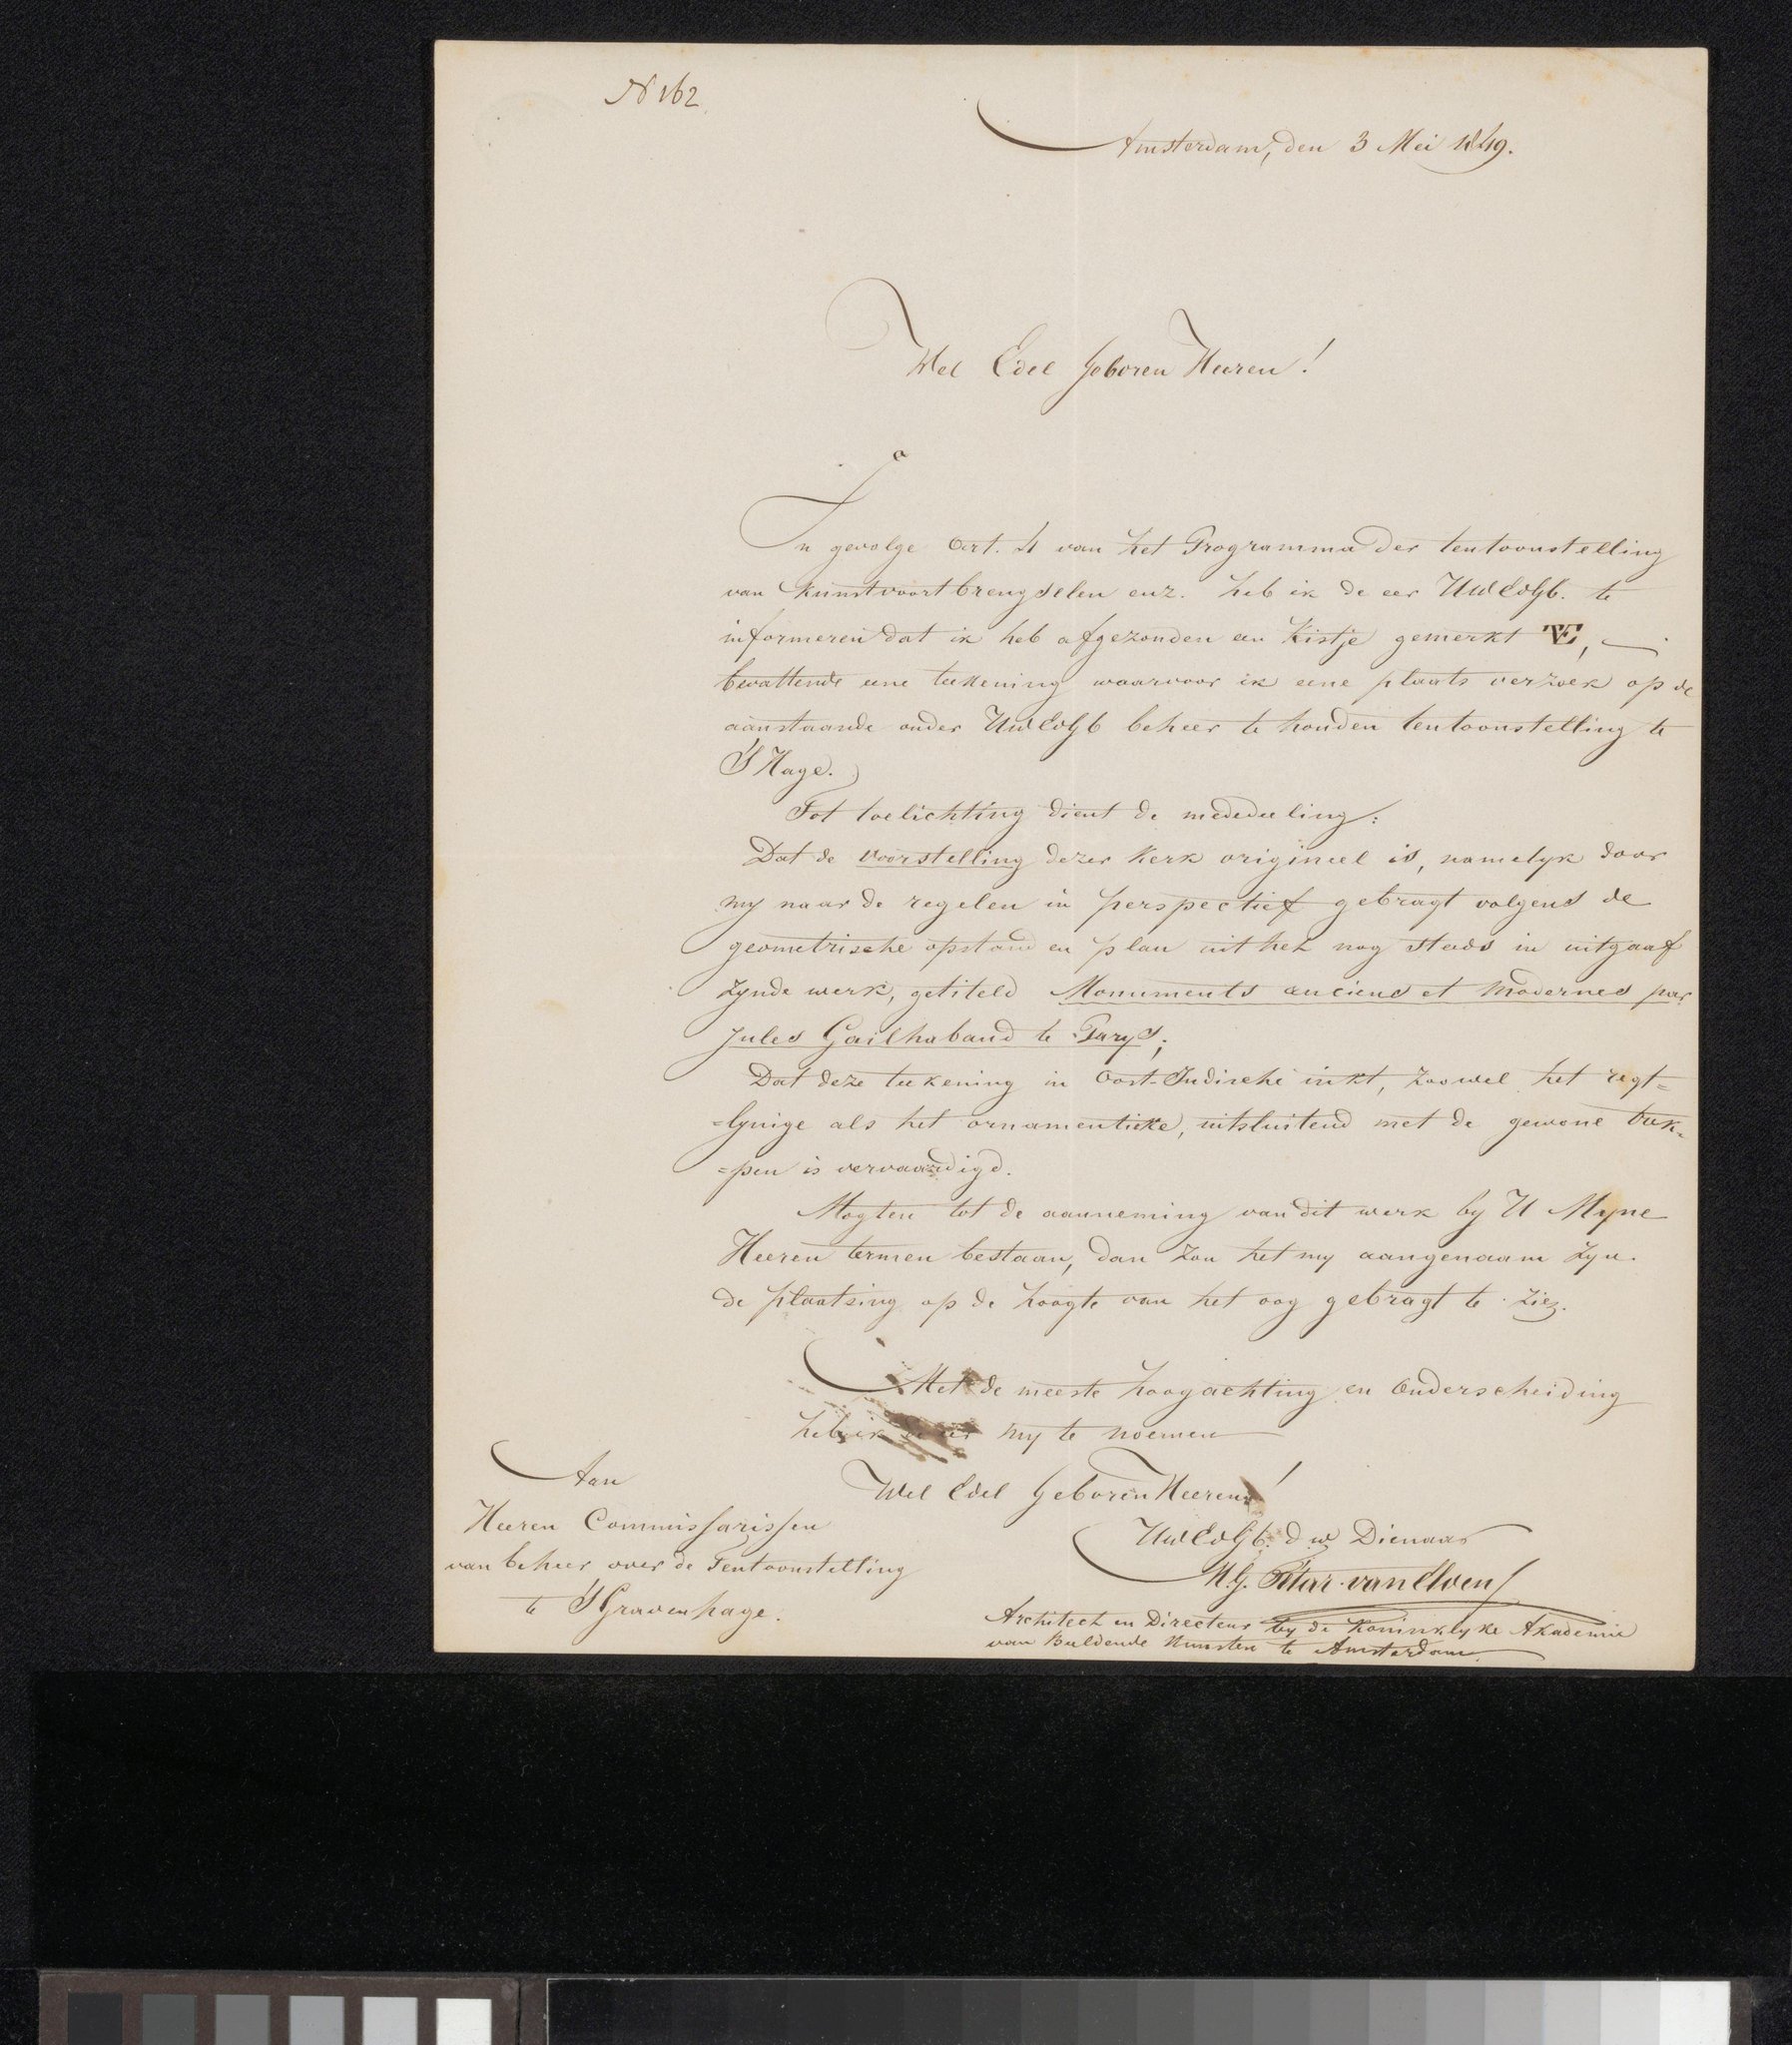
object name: letter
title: Brief aan de commissie van de Tentoonstelling van Levende Meesters in Den Haag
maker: martinus gerardus tetar van elven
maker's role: architect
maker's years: 1803-1882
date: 1849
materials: ink, paper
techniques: pen, writing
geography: amsterdam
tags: drawing, exhibition ~ art